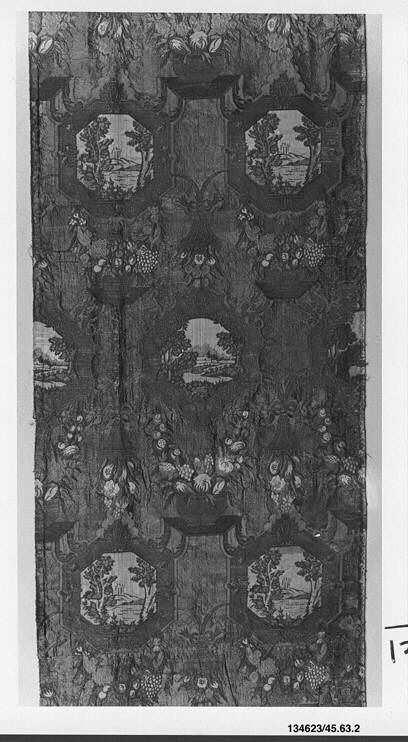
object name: panel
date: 1735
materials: metal thread, silk